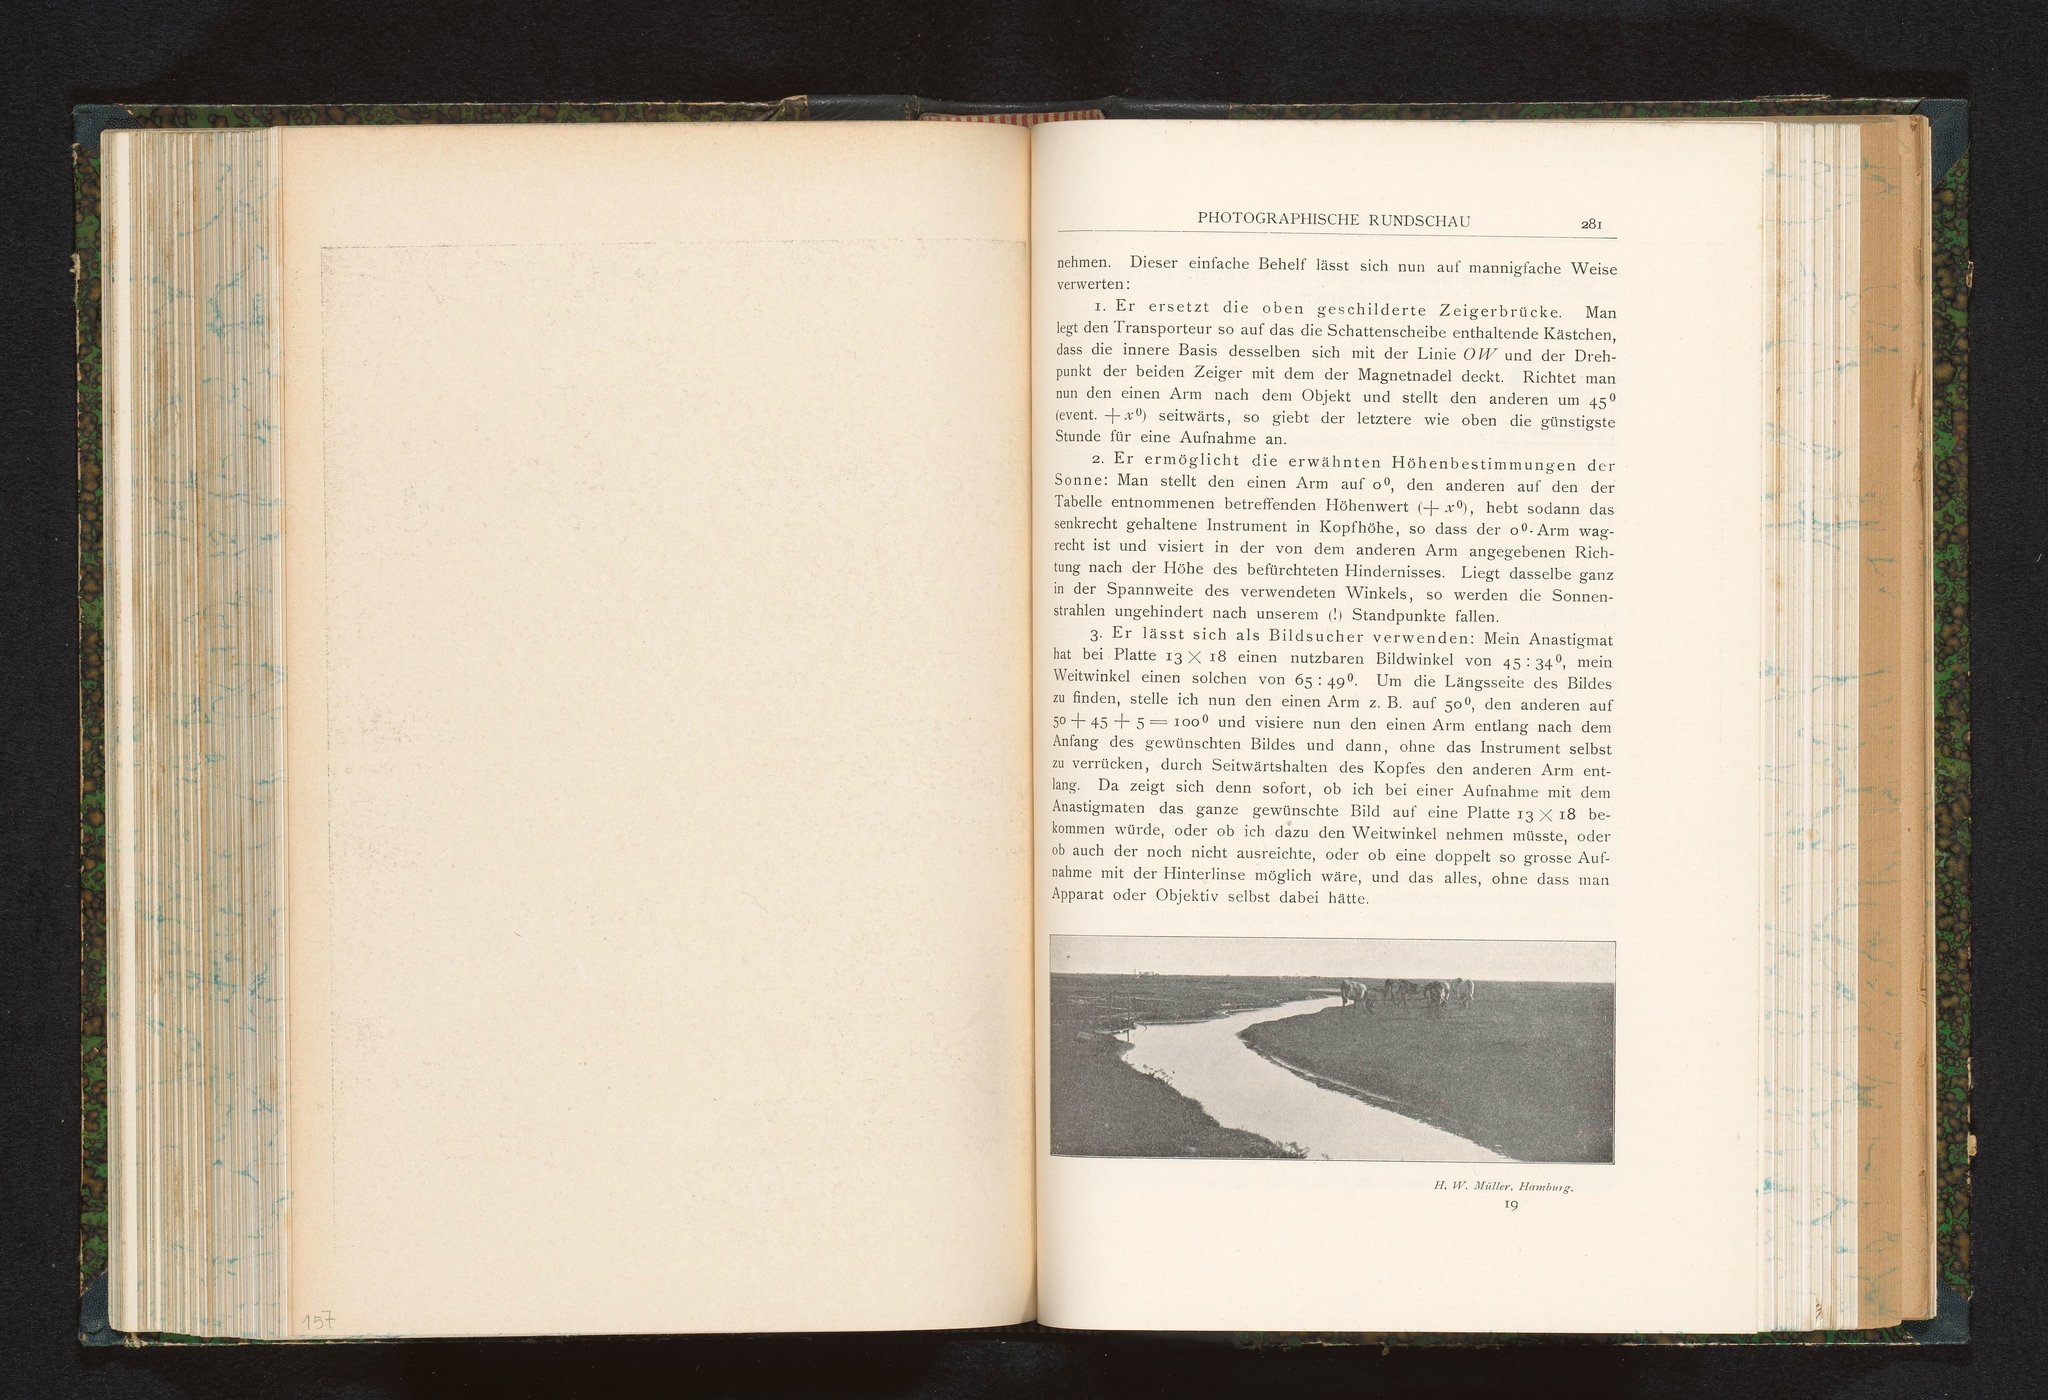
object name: photomechanical print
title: Koeien in een weiland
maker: otto h. müller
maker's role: fotograaf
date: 1894-1899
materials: paper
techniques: autotype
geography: berlin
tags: cow, meadow, pasture